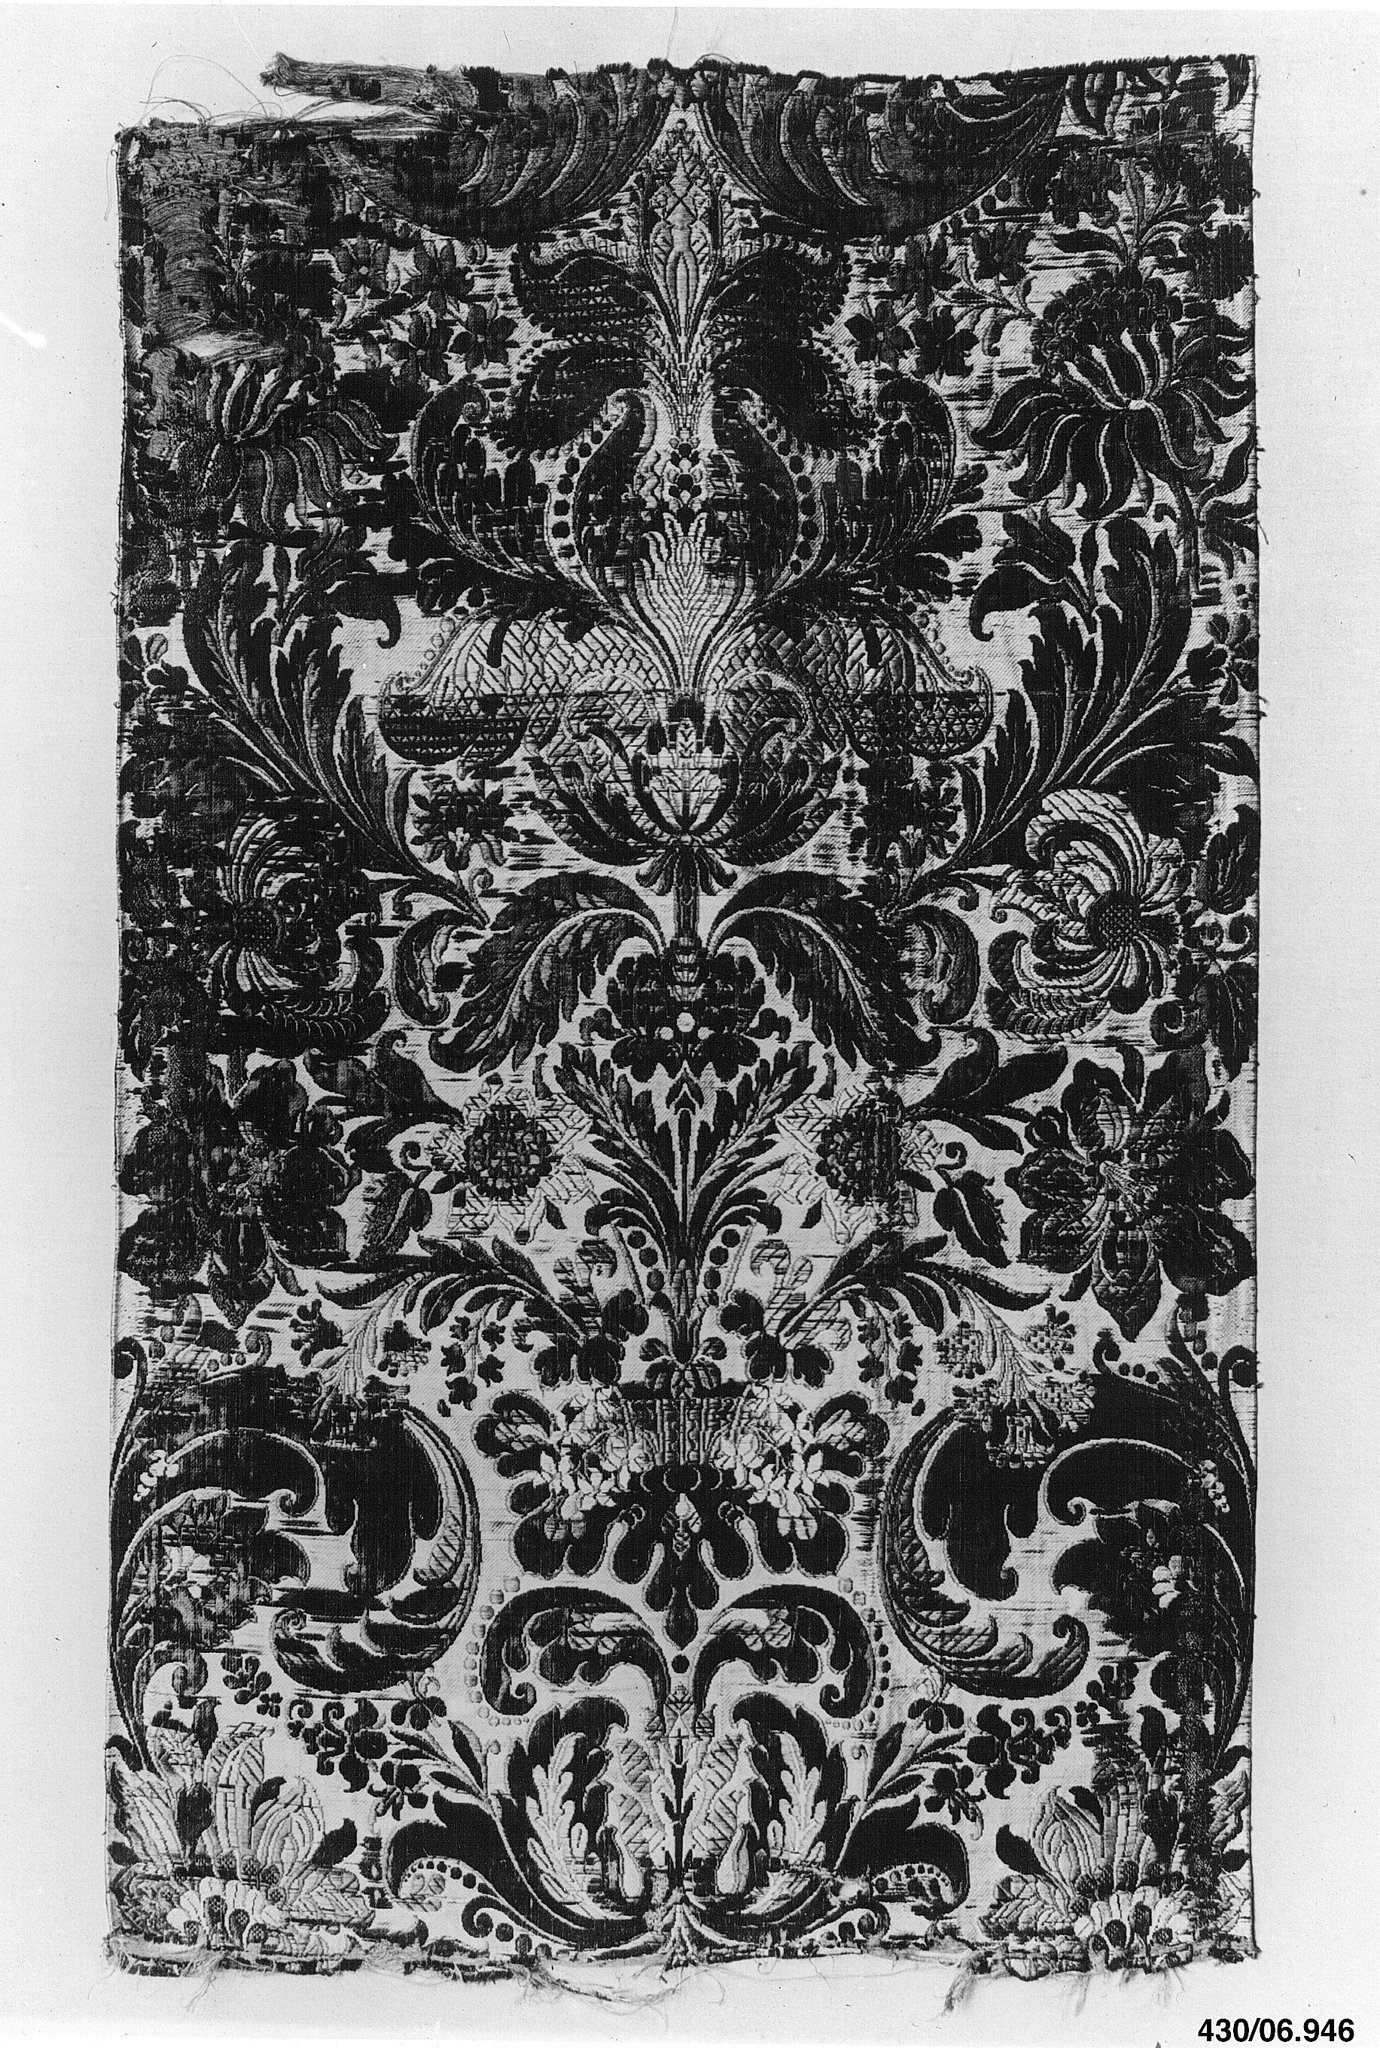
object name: piece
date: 1705-1715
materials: hemp, silk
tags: flowers,leaves